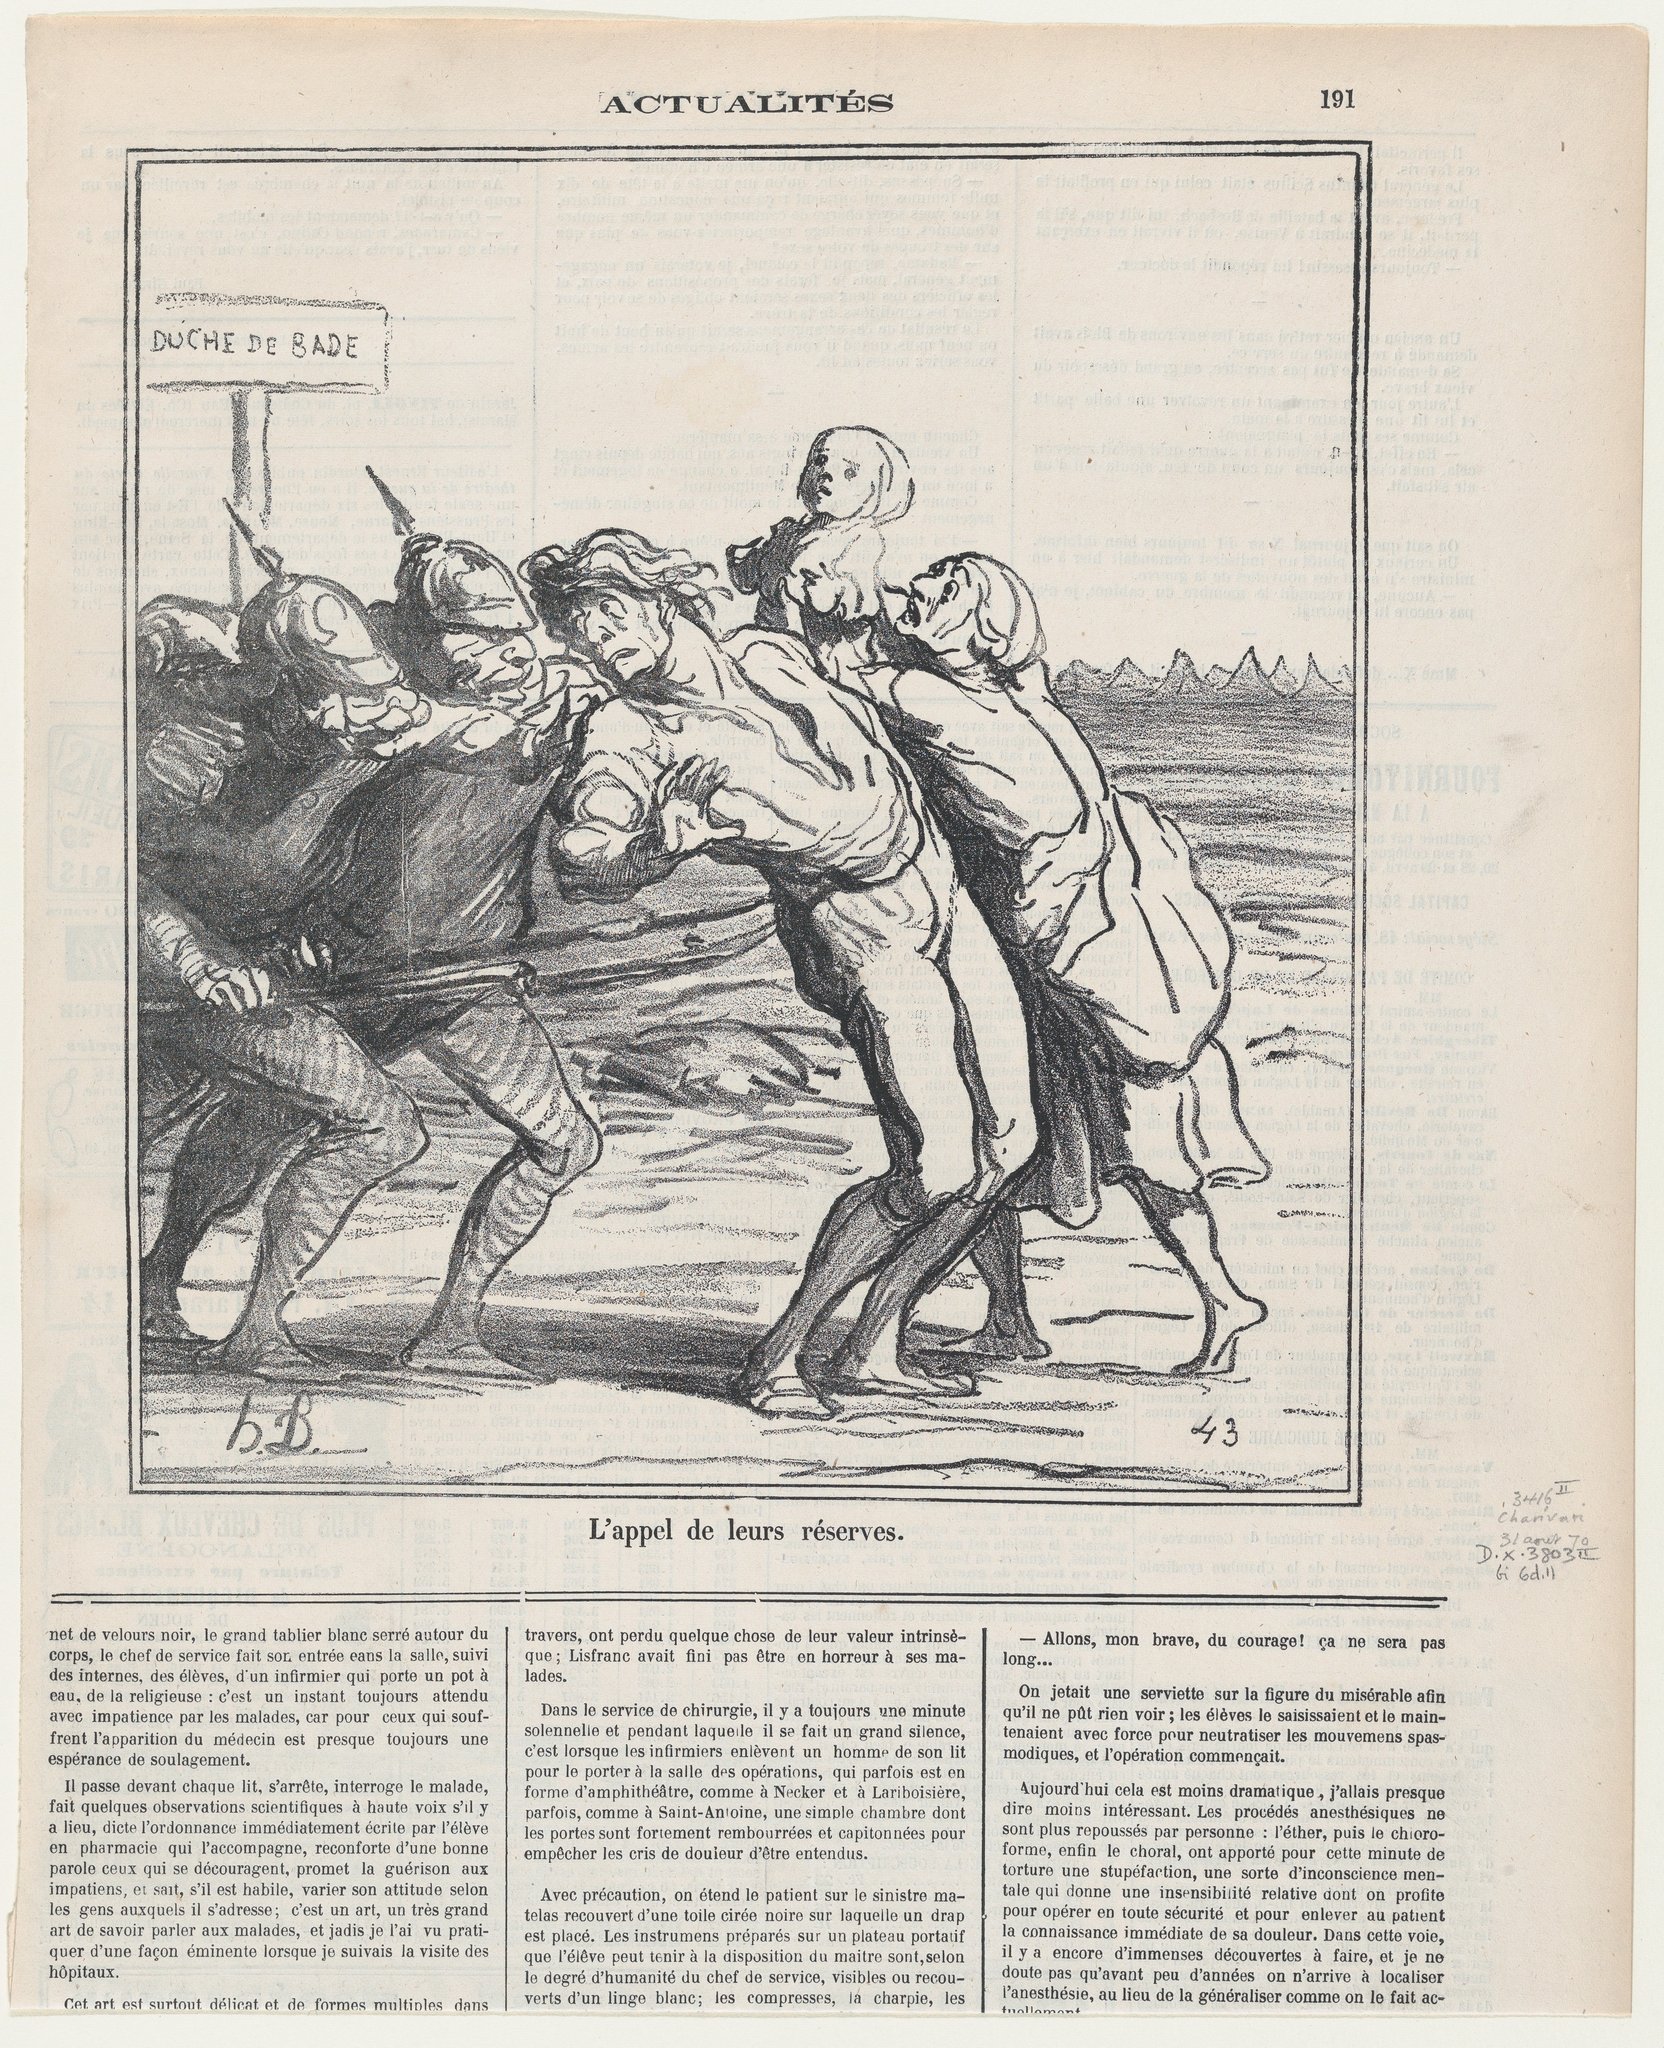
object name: print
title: Calling their reserve conscripts to the colors, from 'News of the day,' published in Le Charivari, August 31, 1870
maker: honoré daumier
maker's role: artist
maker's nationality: french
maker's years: 1808-1879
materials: paper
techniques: lithograph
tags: suffering,infants,men,women